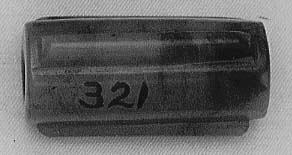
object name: tassel slide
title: Tassel-slide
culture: chinese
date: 206 BCE-220 CE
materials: jade